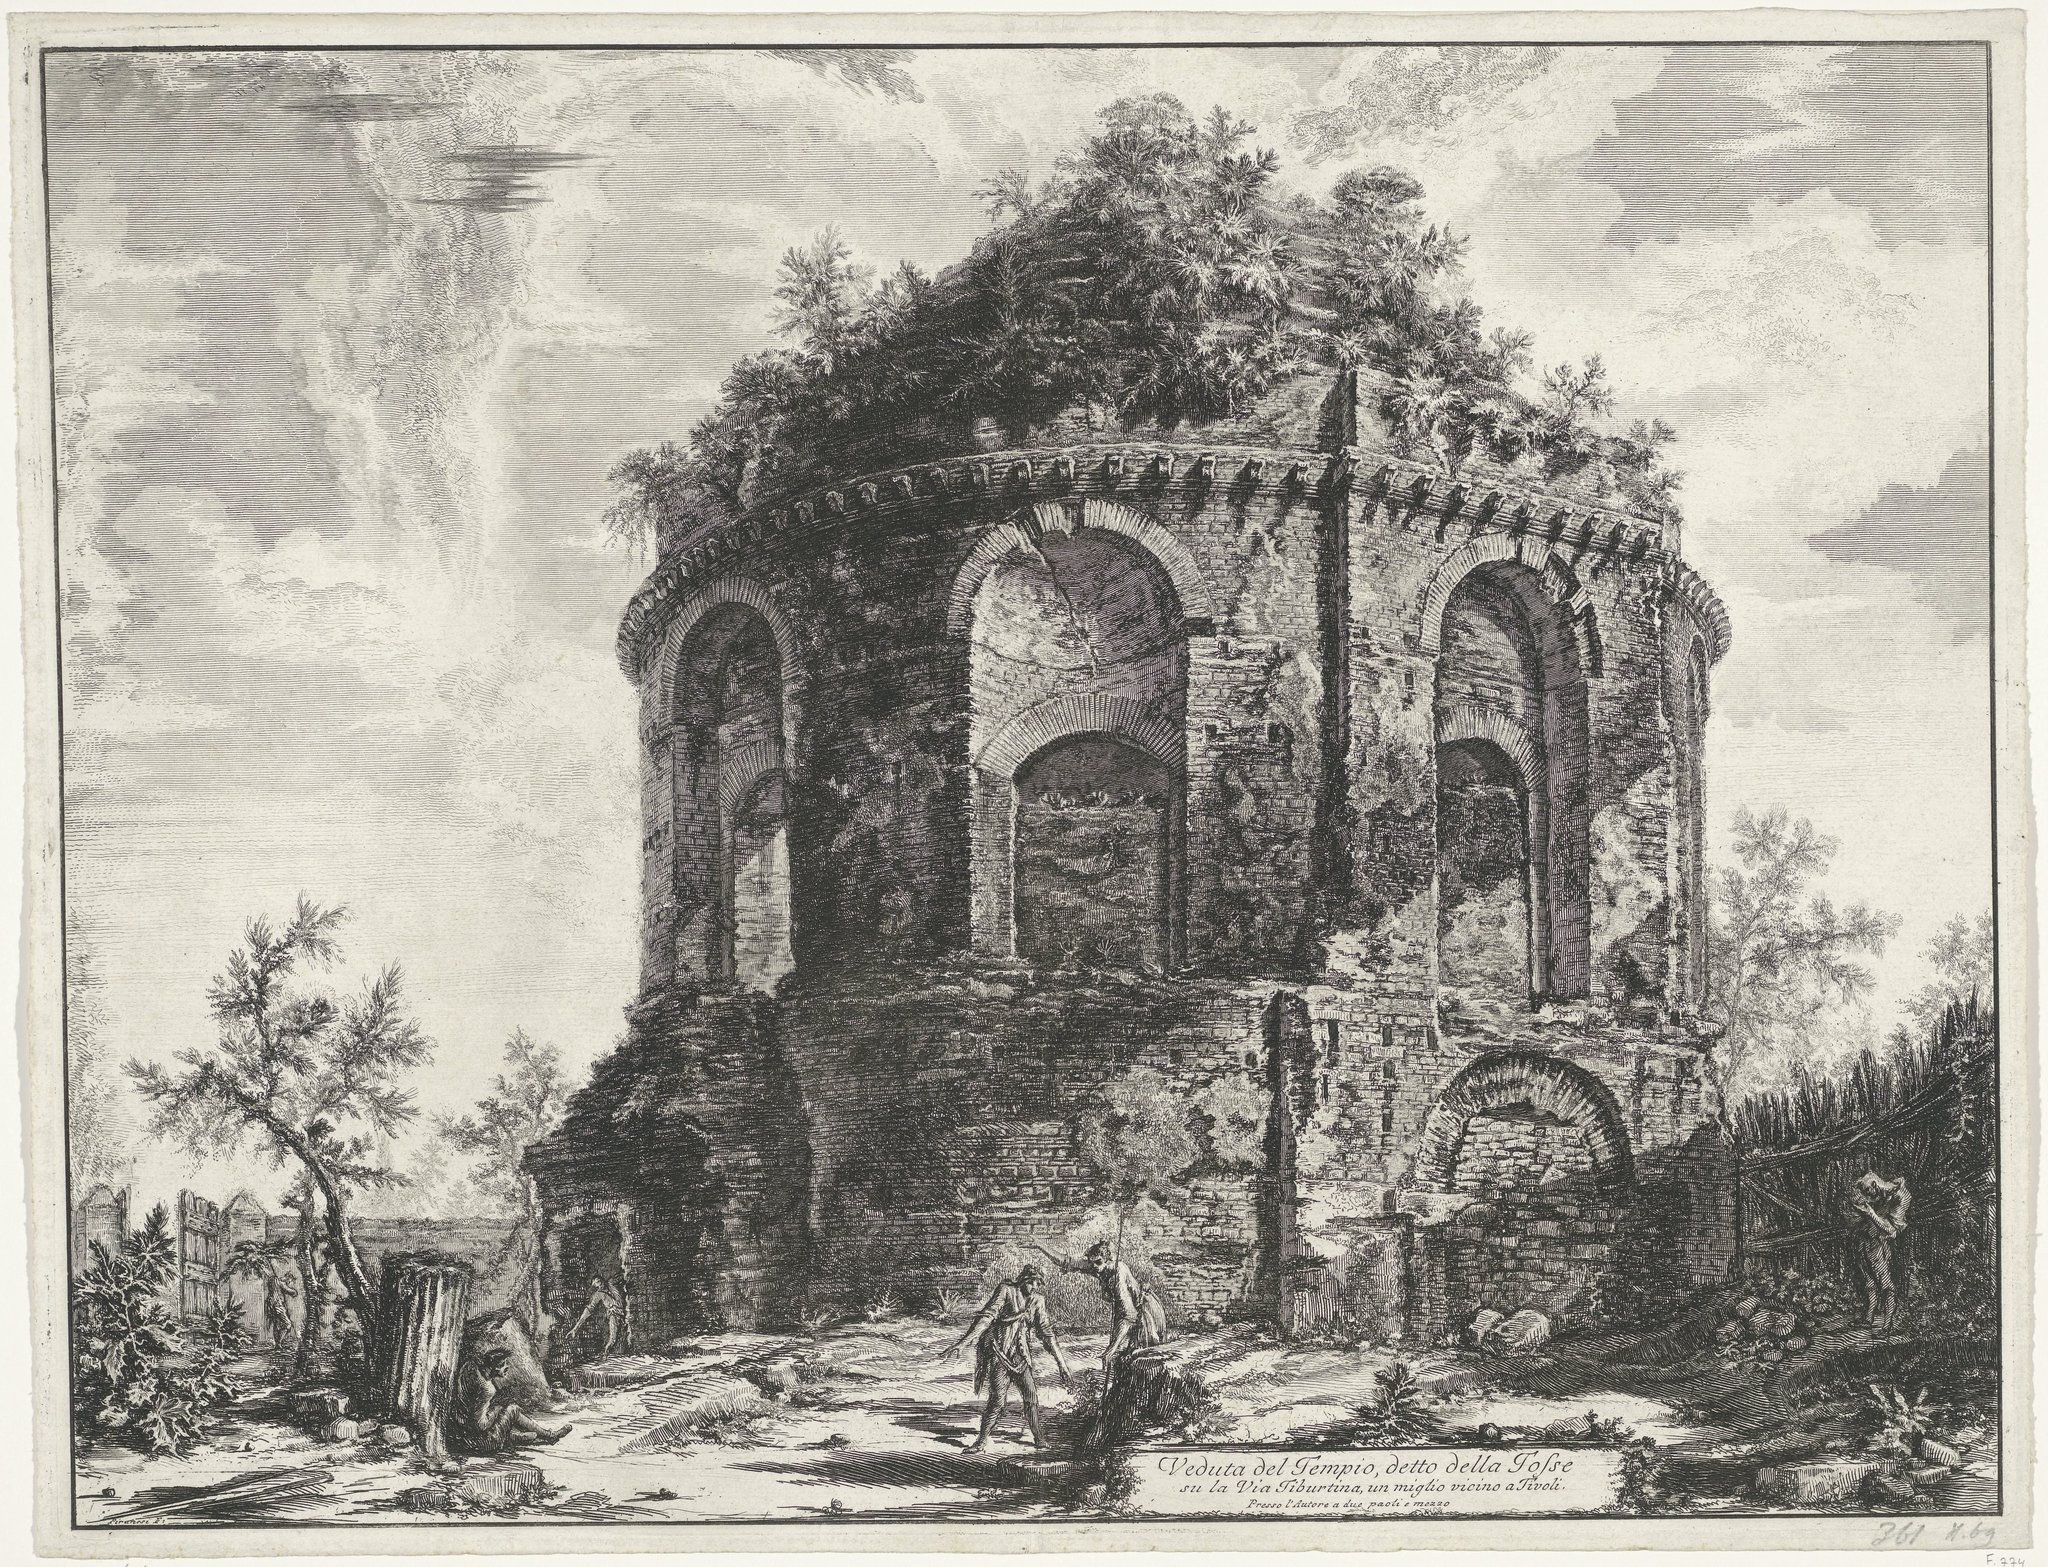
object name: print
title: Tempio della Tosse bij Tivoli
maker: giovanni battista piranesi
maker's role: designer, draughtsman, print maker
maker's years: 1720-1778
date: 1748-1778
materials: paper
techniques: etching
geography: rome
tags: ruin of a building ~ architecture, landscape with ruins, temple, shrine ~ roman religion, tivoli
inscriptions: collector's mark: Lugt 2228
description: Deze prent maakt deel uit van de serie 'Vedute di Roma'. Piranesi werkte aan deze 135 platen tellende serie tussen 1748 en zijn dood in 1778. Francesco Piranesi voegde later nog twee prenten toe aan de reeks van zijn vader.